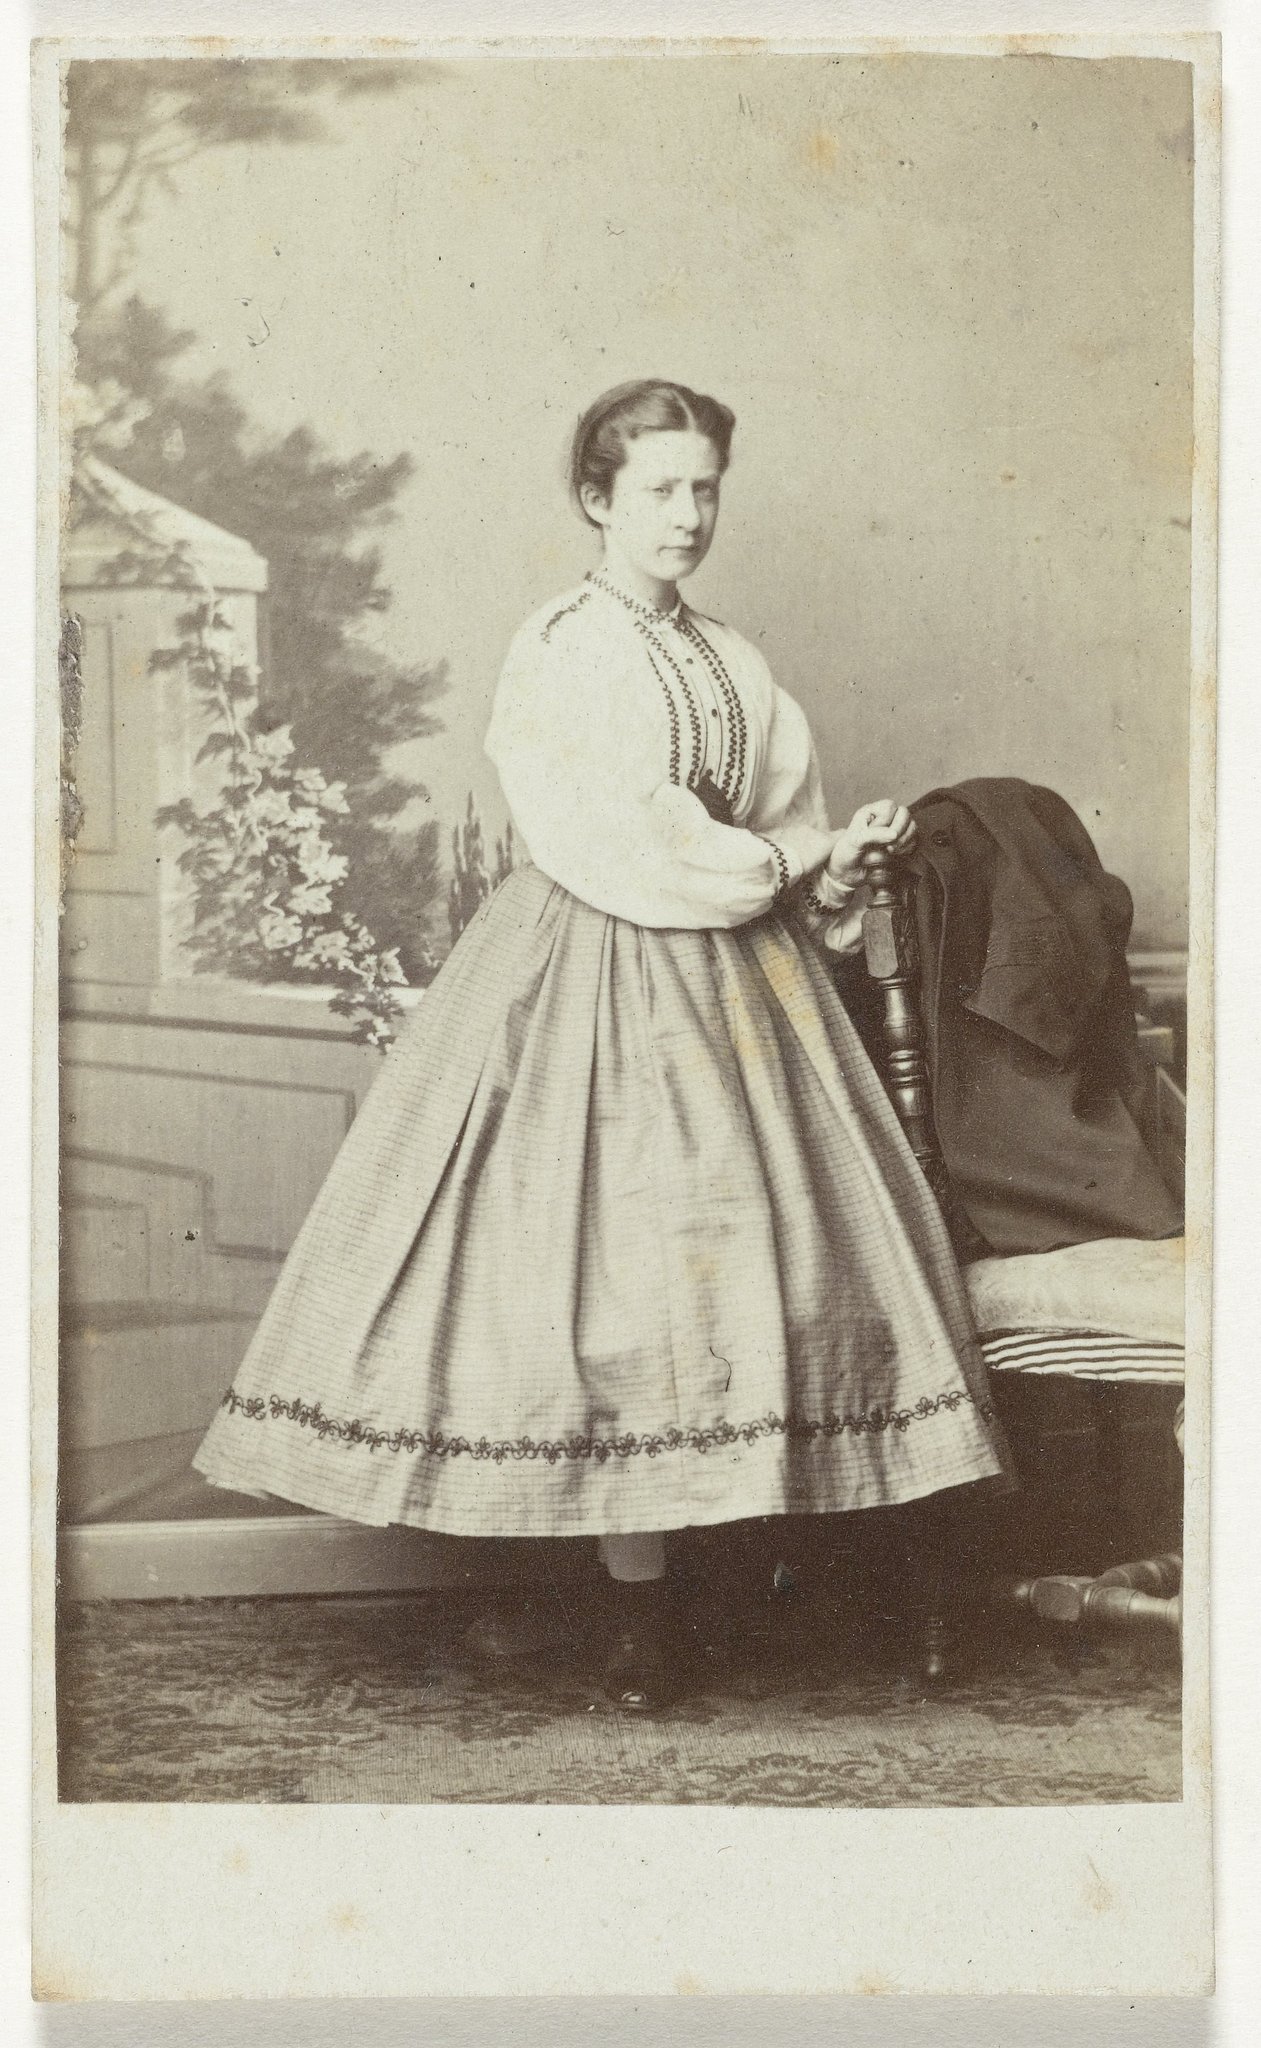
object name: carte de visite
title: Portret van een vrouw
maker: f. kaijser (i)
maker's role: fotograaf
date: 1863-1864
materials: cardboard, paper, photographic support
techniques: albumen print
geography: zwolle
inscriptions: address: ‘F.Kaijser/Photograph/Utrecht-Zwolle/(N.G.Plompetoren)(buiten de Sassenpoort)’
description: Staande vrouw in witte bloes en wijde, lichte rok, bij stoel. Afbeelding van begroeide muur als achtergrond.